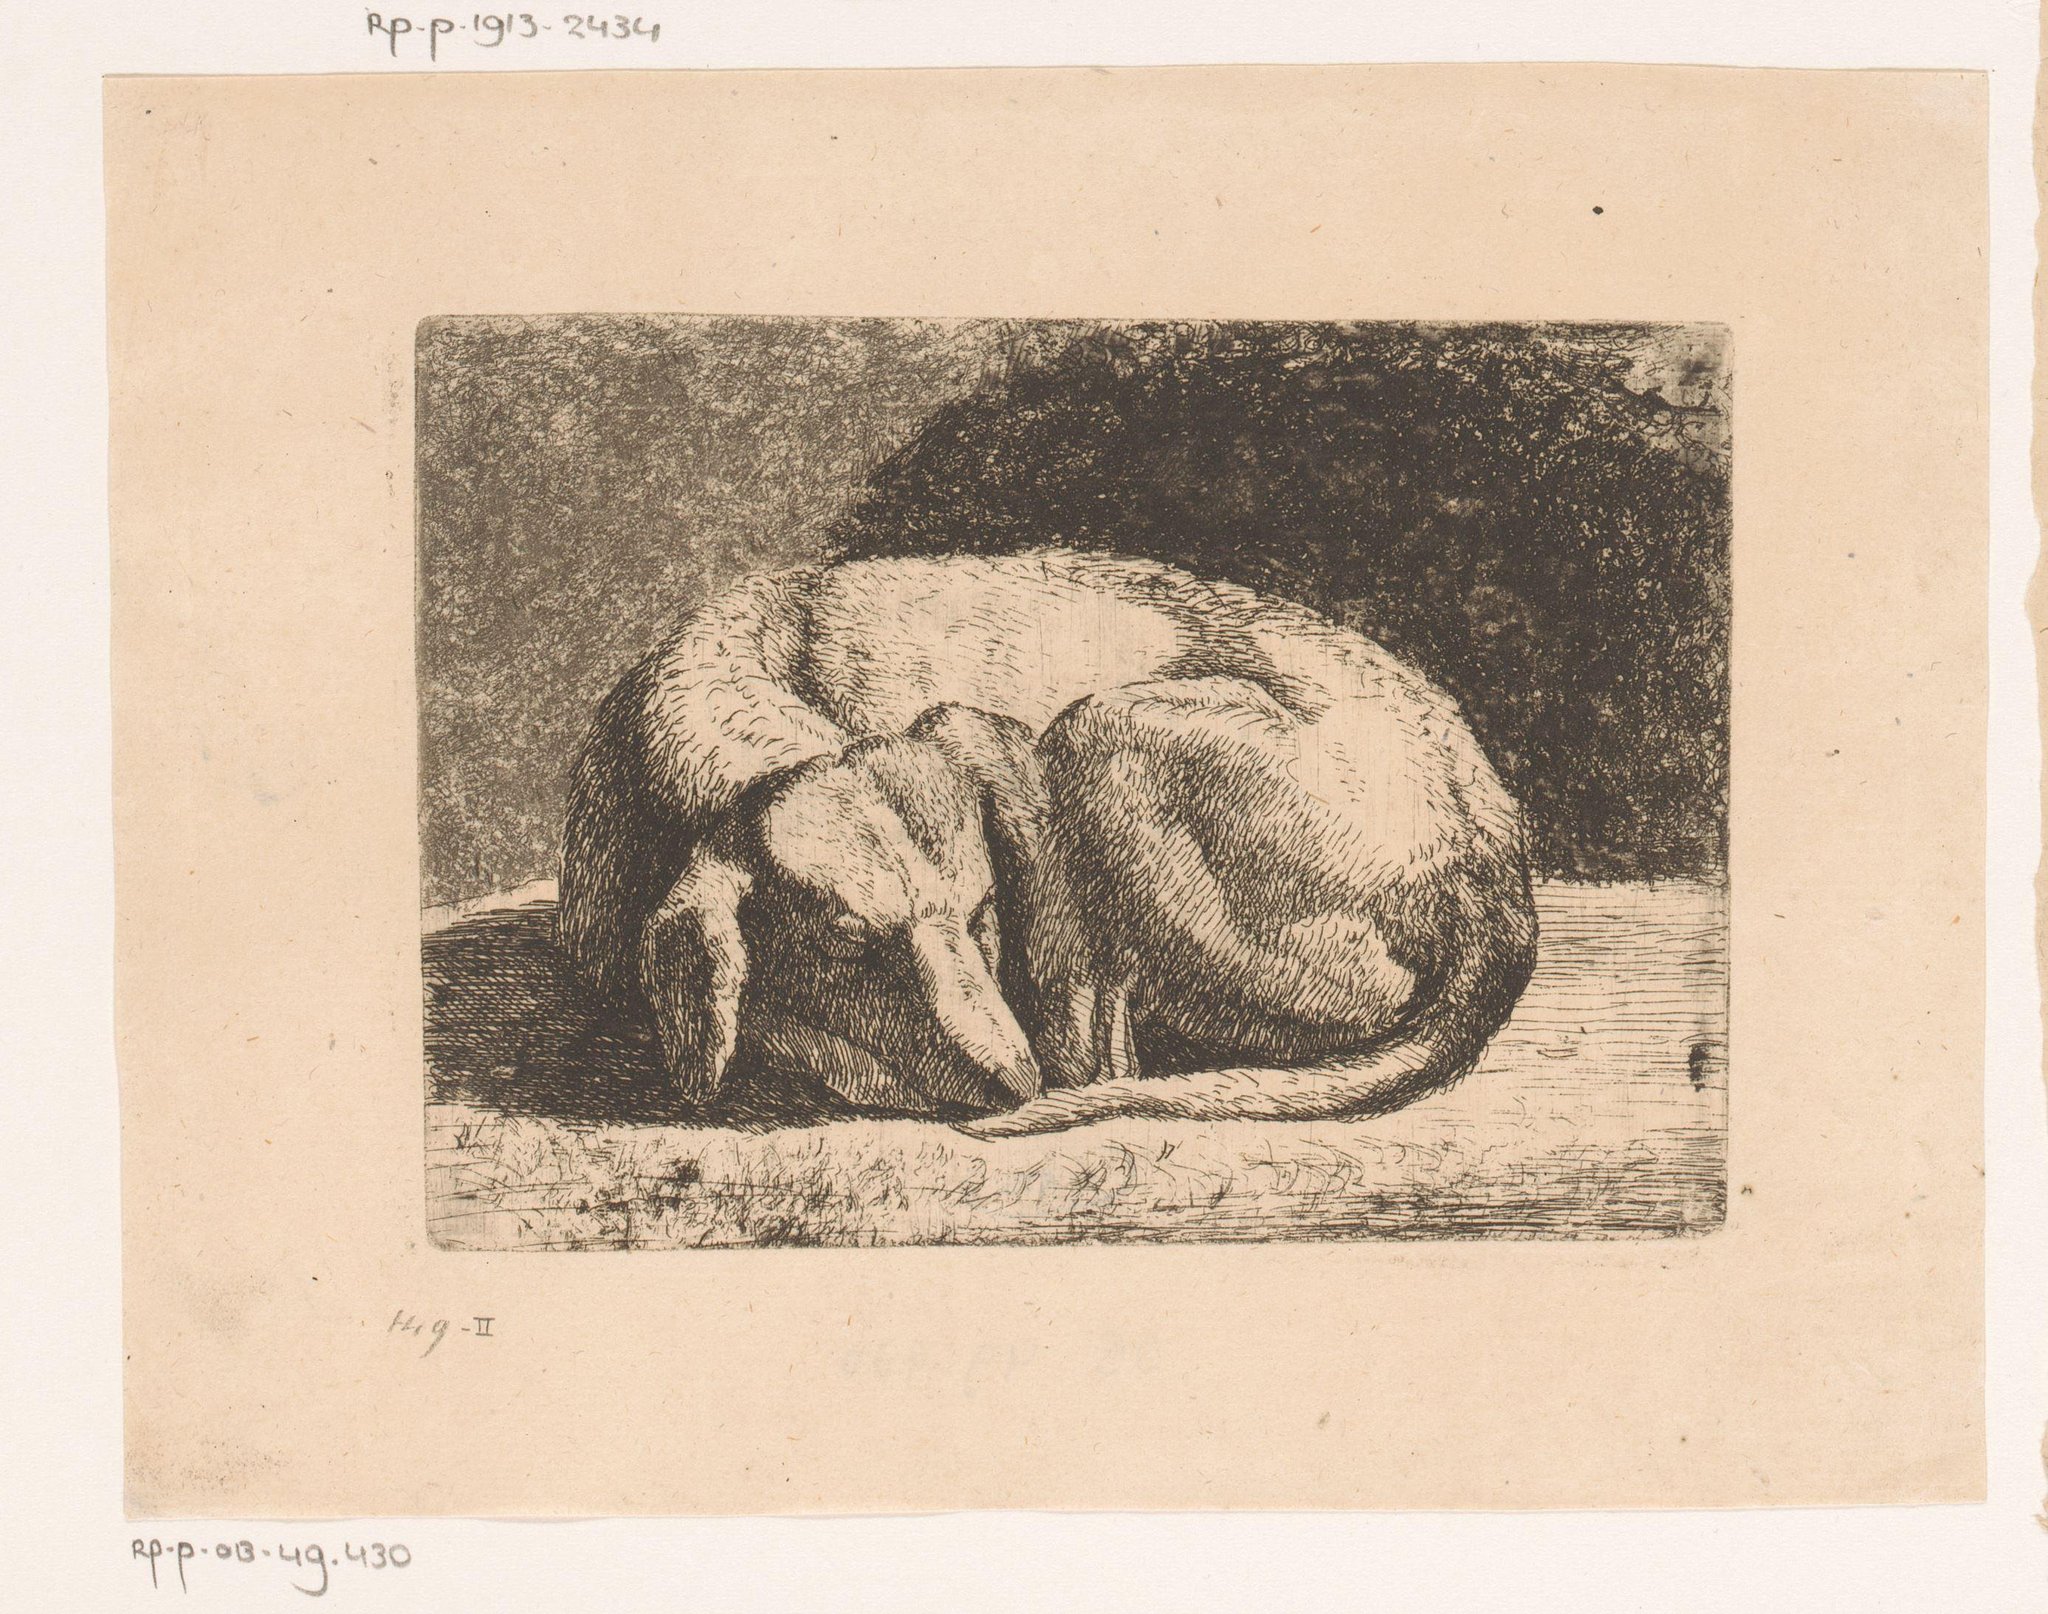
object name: print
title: Slapende hond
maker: hendrik jozef franciscus van der poorten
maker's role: draughtsman, print maker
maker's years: 1789-1874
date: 1842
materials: paper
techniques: aquatint, drypoint, etching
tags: dog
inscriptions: collector's mark: Lugt 2228